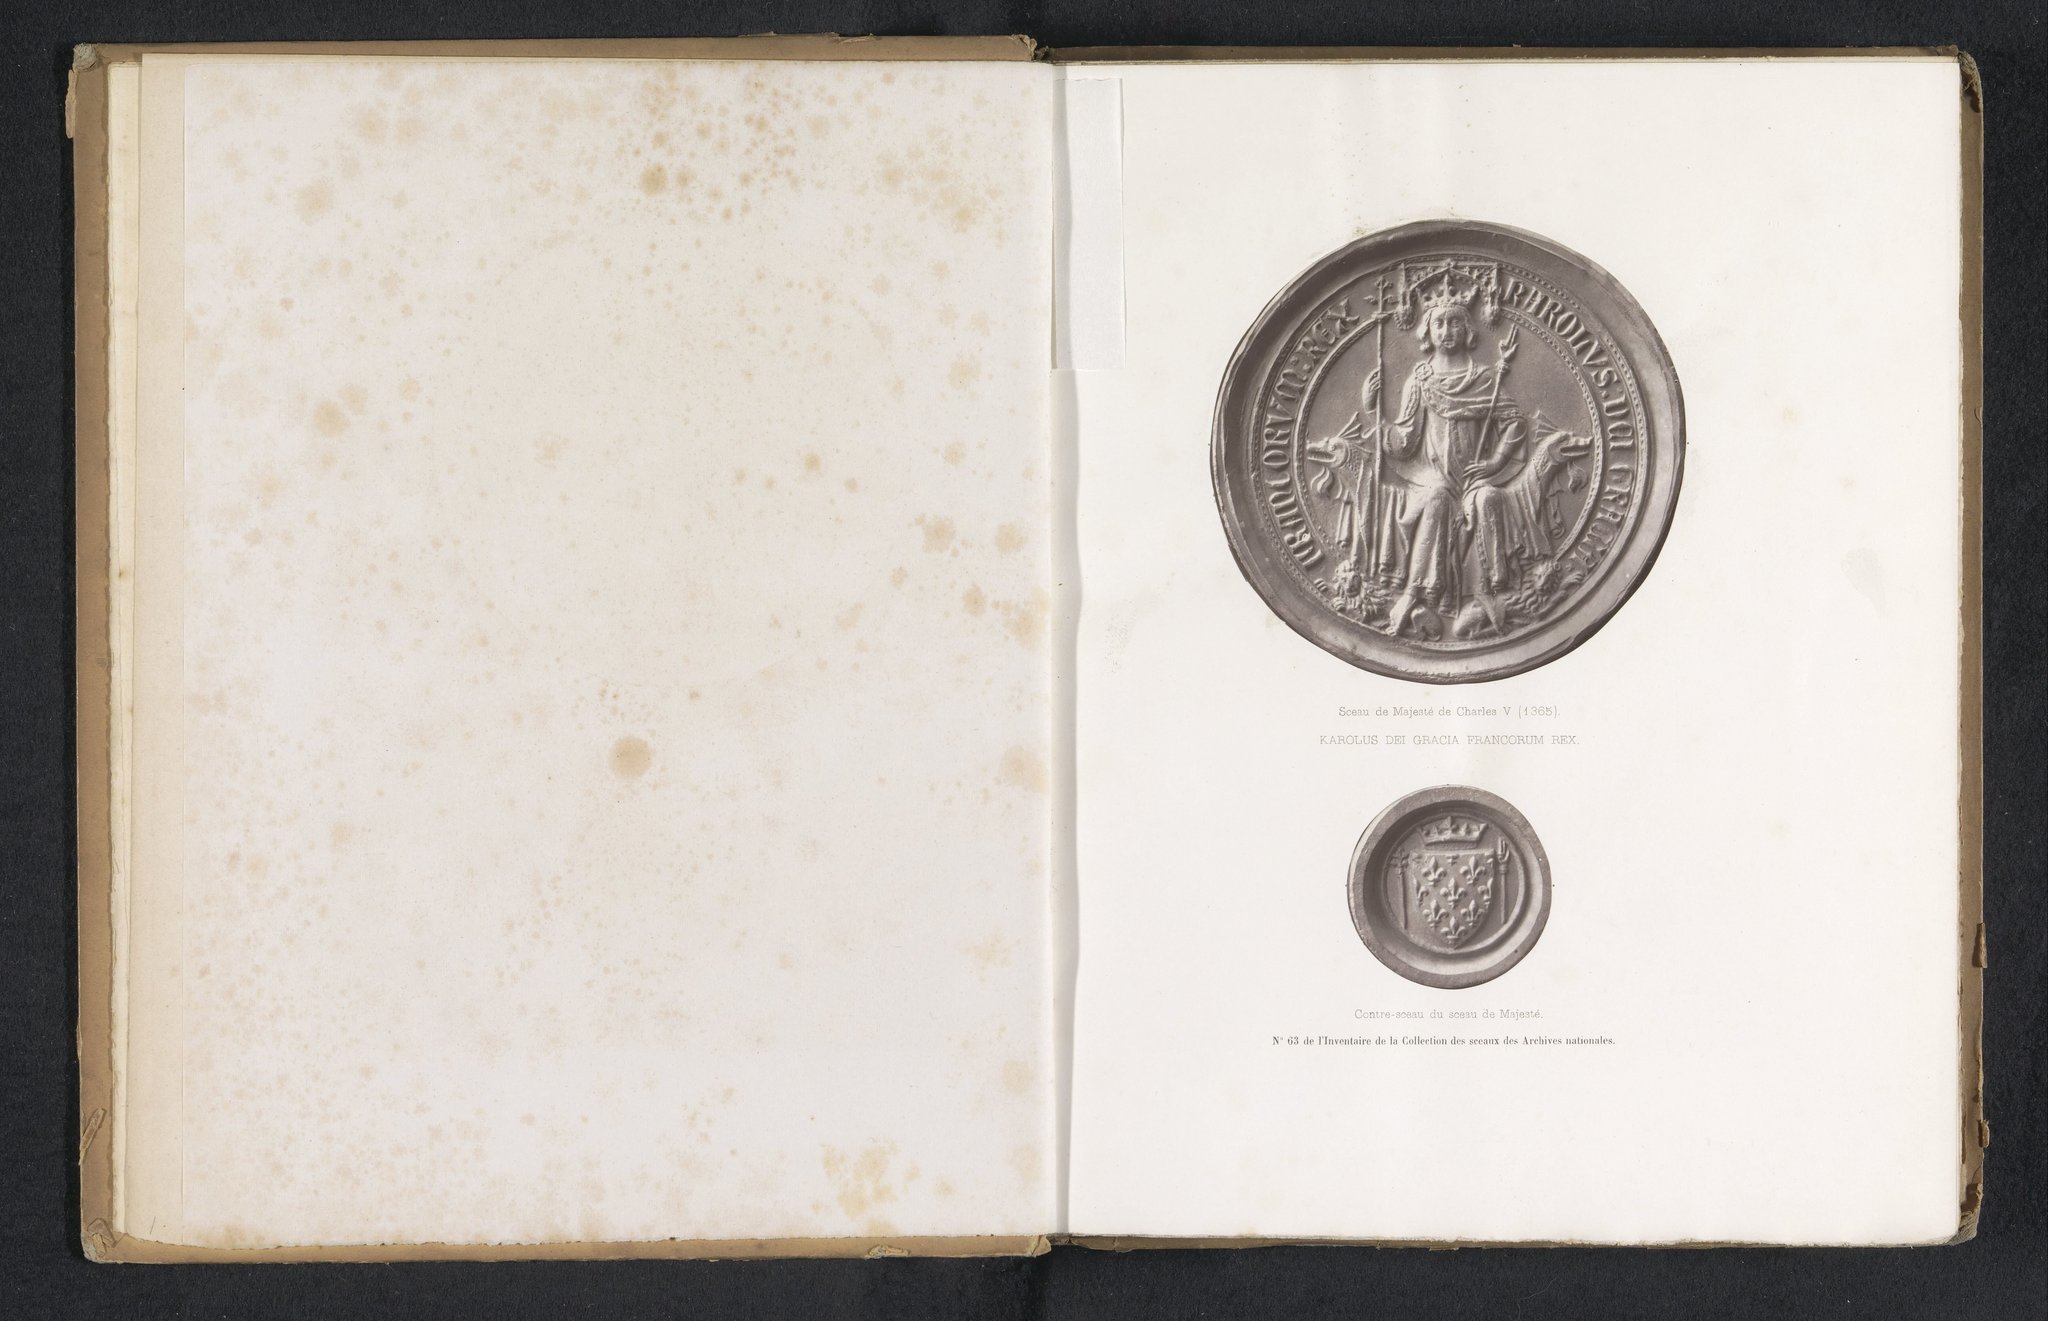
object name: page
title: Sceau de Majesté de Charles V (1365)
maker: Anonymous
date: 1869-1879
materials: paper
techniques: woodburytype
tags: coat of arms (symbol of sovereignty), coin, ruler, sovereign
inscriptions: inscription: ‘No 63 de l'Inventaris de la Collection des sceaux des Archives nationales.’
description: Boven de kopzijde met een afbeelding van koning Karel V van Frankrijk, onder de muntzijde met een wapenschild met Franse lelies.